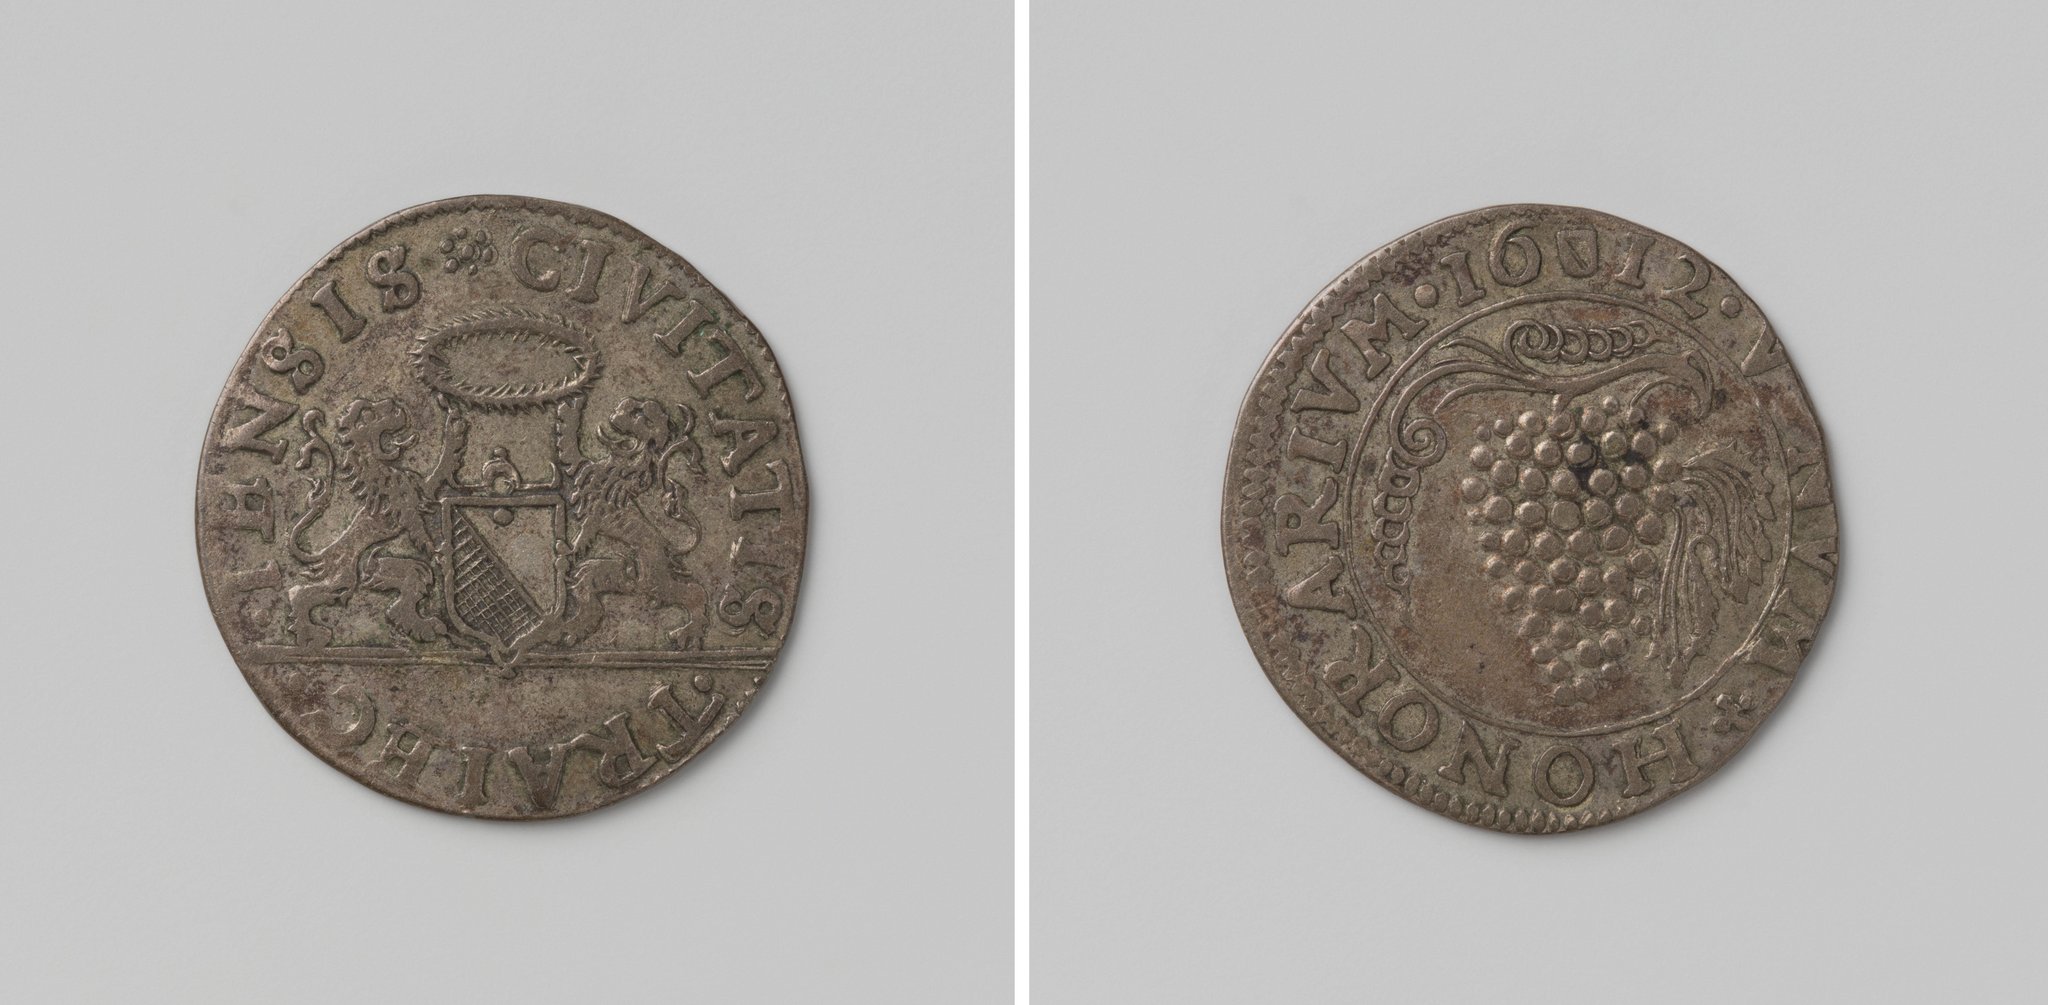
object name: marksman medal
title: Schutterij van Utrecht, penning die schutters recht gaf op een kan wijn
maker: Anonymous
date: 1612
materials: silver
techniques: striking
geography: utrecht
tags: utrecht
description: Zilveren wijn- en schutterspenning van Utrecht. Voorzijde: wapenschild, waarboven twee leeuwen lauwerkrans houden binnen omschrift. Keerzijde: tros druiven binnen omschrift